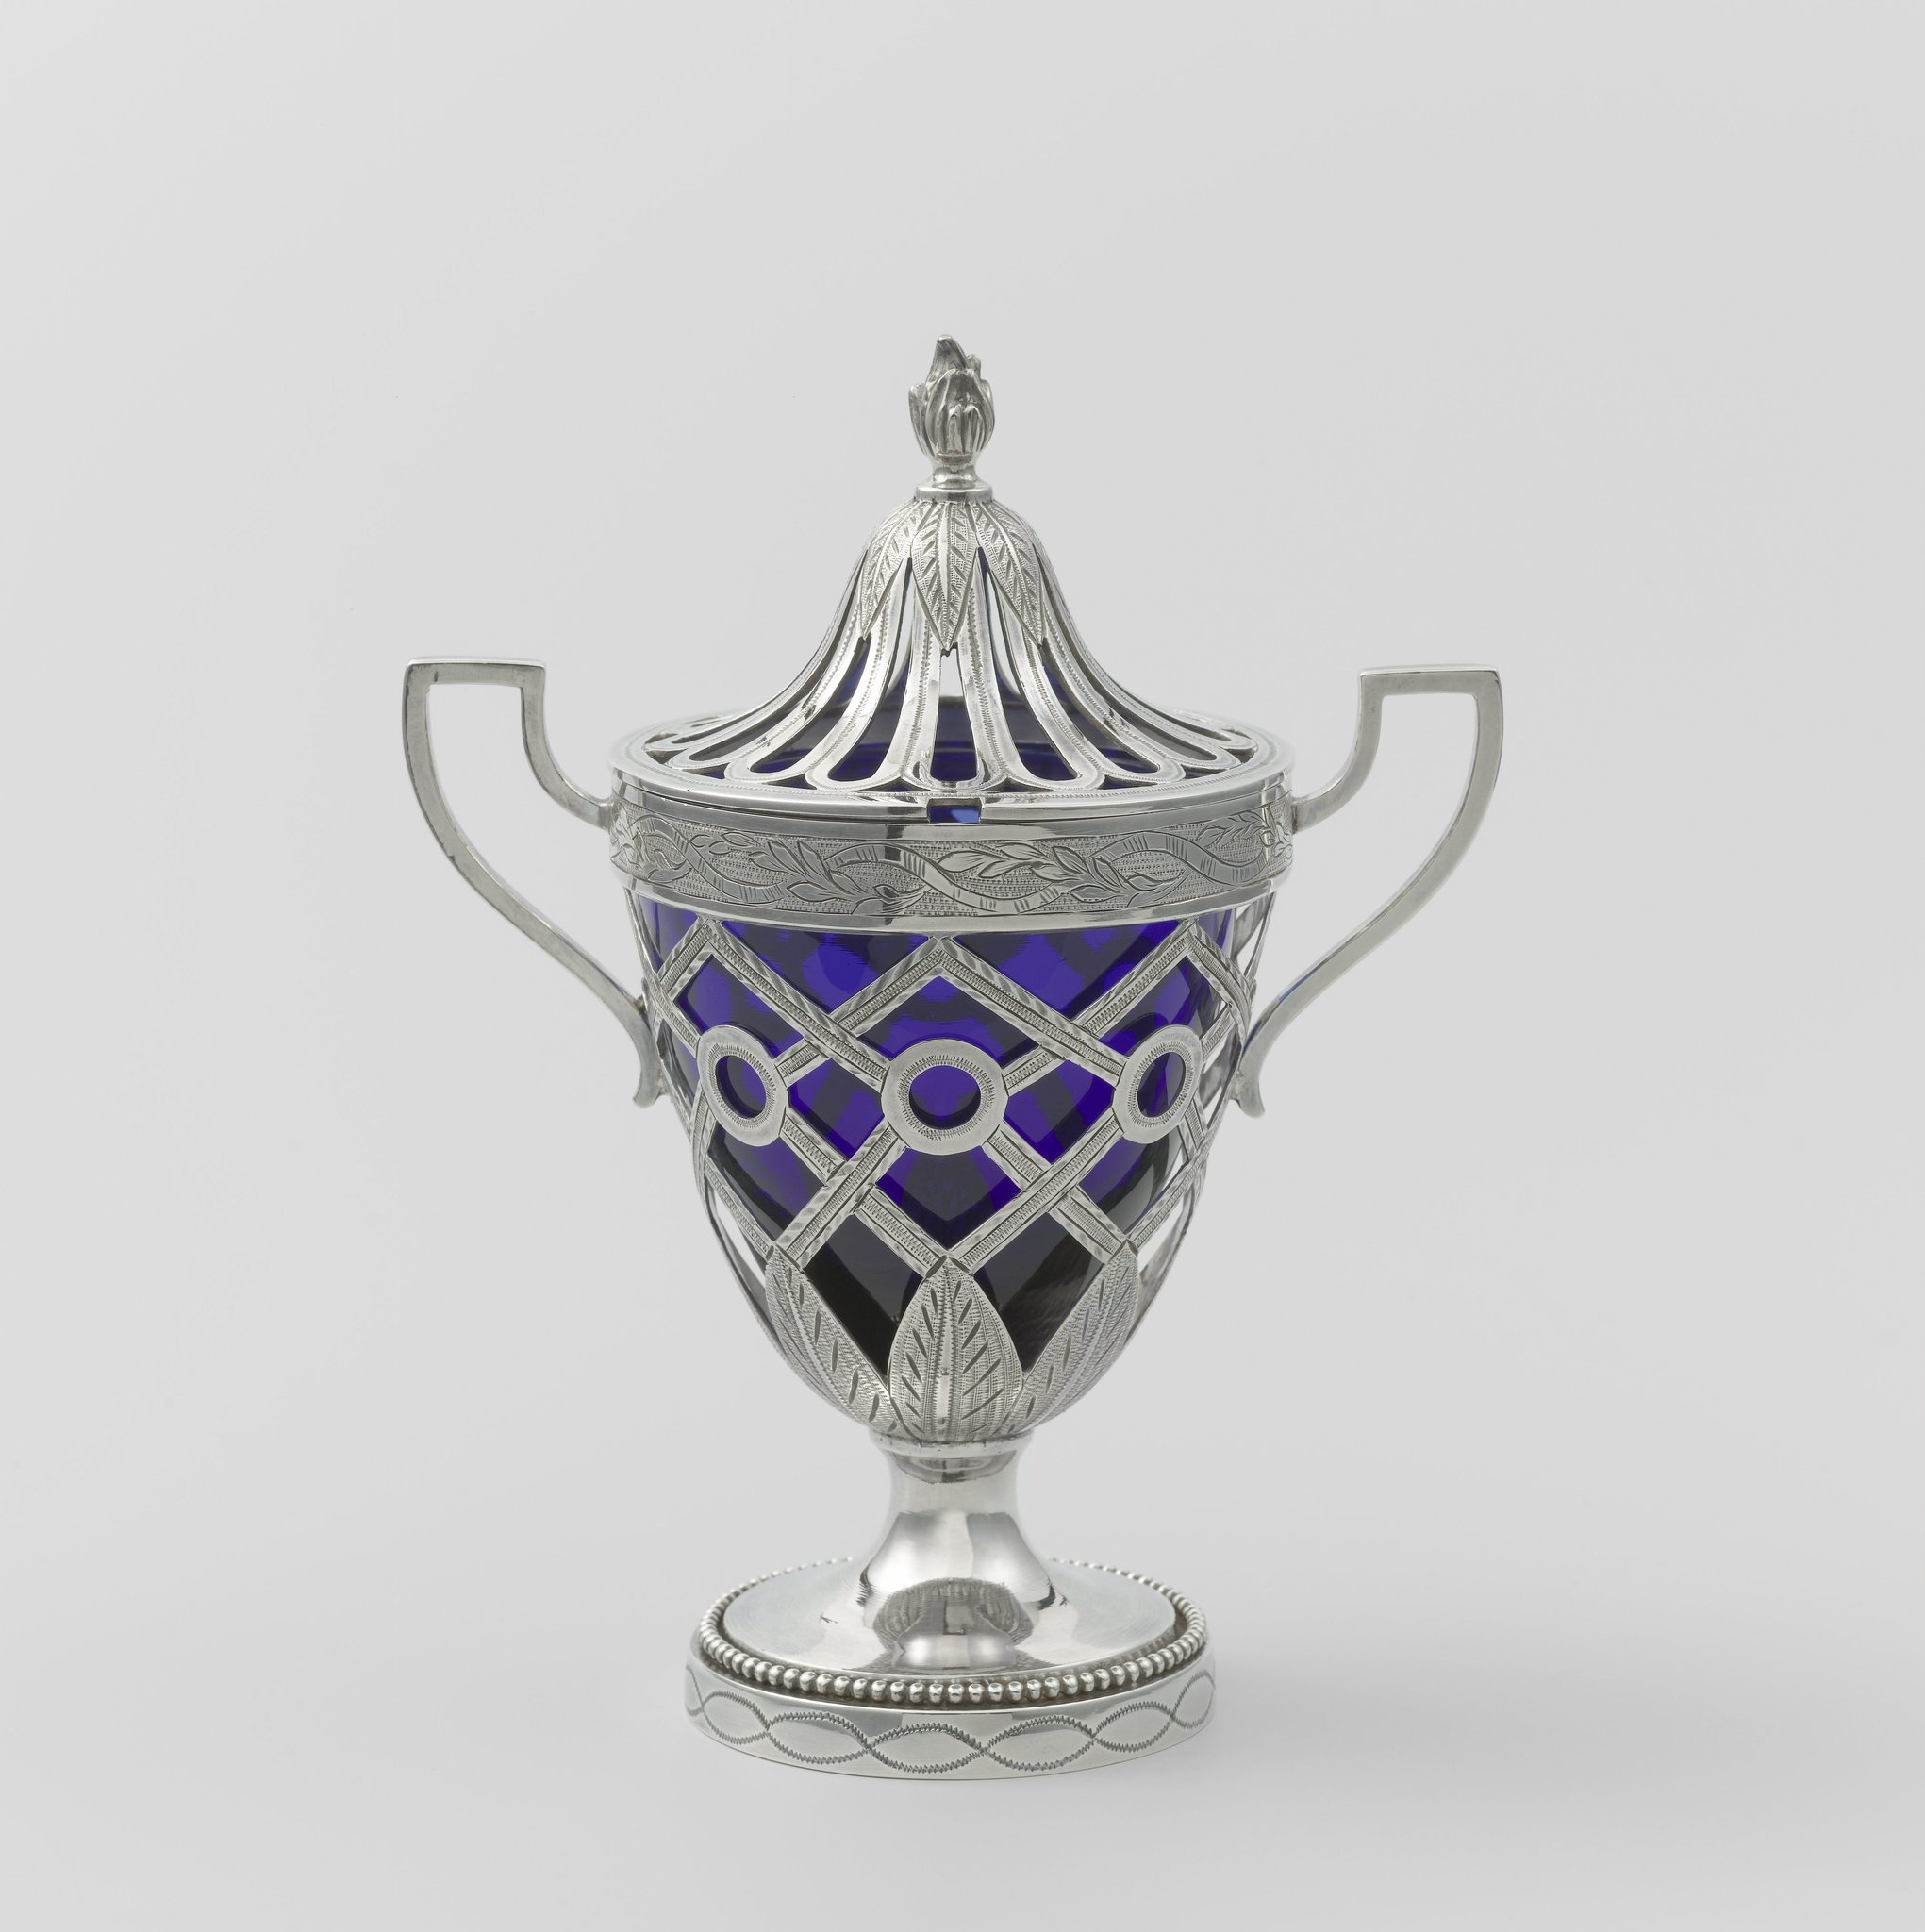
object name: mustard pot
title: Mosterdpot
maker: martinus van stapele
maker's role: silversmith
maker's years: 1731-1803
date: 1787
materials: glass, silver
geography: the hague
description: Mosterdpot, rond, met los deksel en een losse binnenbak van blauw glas. Het gewelfde lichaam rust op een zich sterk verjongende voet op een rechtwandige, inspringende basis versierd met elkaar kruisende, in trembleersteek uitgevoerde golflijnen. Daar waar de basis inspringt is een parelrand aangebracht. Het lichaam is opengewerkt met een in diverse graveersteken versierd patroon van laurierbladeren, waarboven elkaar kruisende banden en open cirkels, aan de bovenzijde afgesloten door een brede band, versierd met een doorlopend patroon van een golvende band, doorslingerd met een lauwerkrans, op een geruwd fond. De pot heeft hoge vleugelvormige oren met rechte bovenkanten.Het gewelfde deksel is opengewerkt met getrembleerde knerren en wordt aan de bovenzijde afgesloten door laurierbladeren. Het deksel wordt bekroond door een vlam-vormige knop. In de eveneens met een trembleersteek versierde onderrand van het deksel bevindt zich een rechthoekige uitsparing waarin het (verloren gegane) mosterdlepeltje gestoken kon worden.